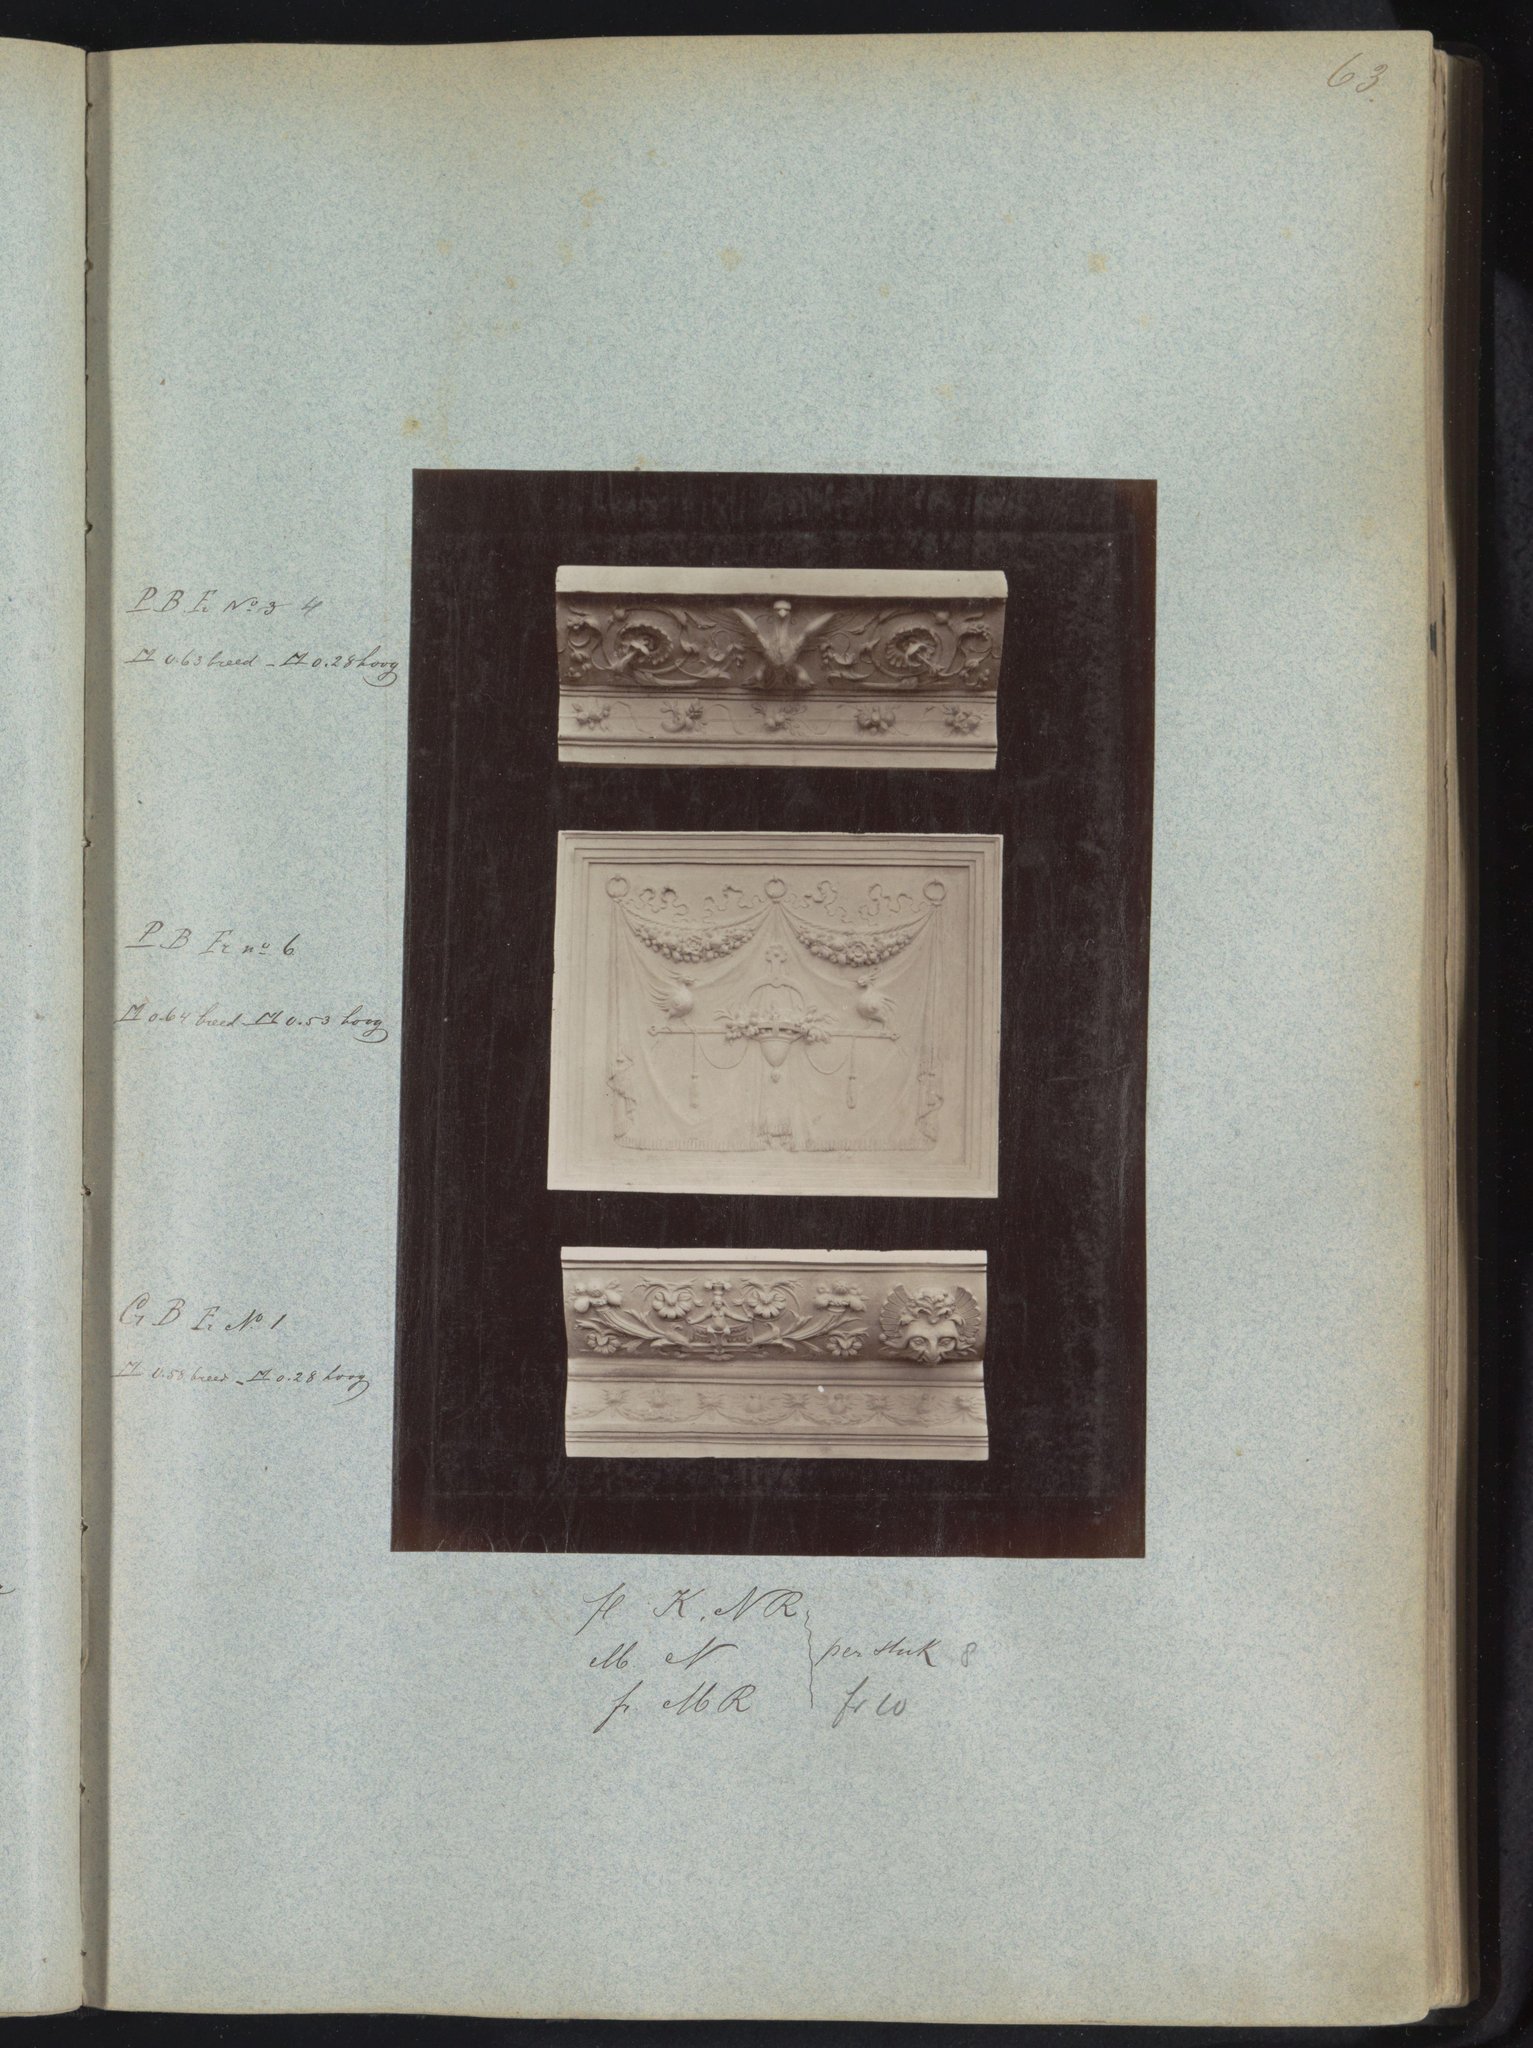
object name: album leaf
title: Gipsen afgietsel van een paneel en van twee friezen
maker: Anonymous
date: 1875-1900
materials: paper, photographic support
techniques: albumen print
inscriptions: annotation, annotation: ‘M 0.63 breed - M 0.28 hoog / M 0.64 breed - 0.53 hoog / M 0.58 breed - M 0.28 hoog’